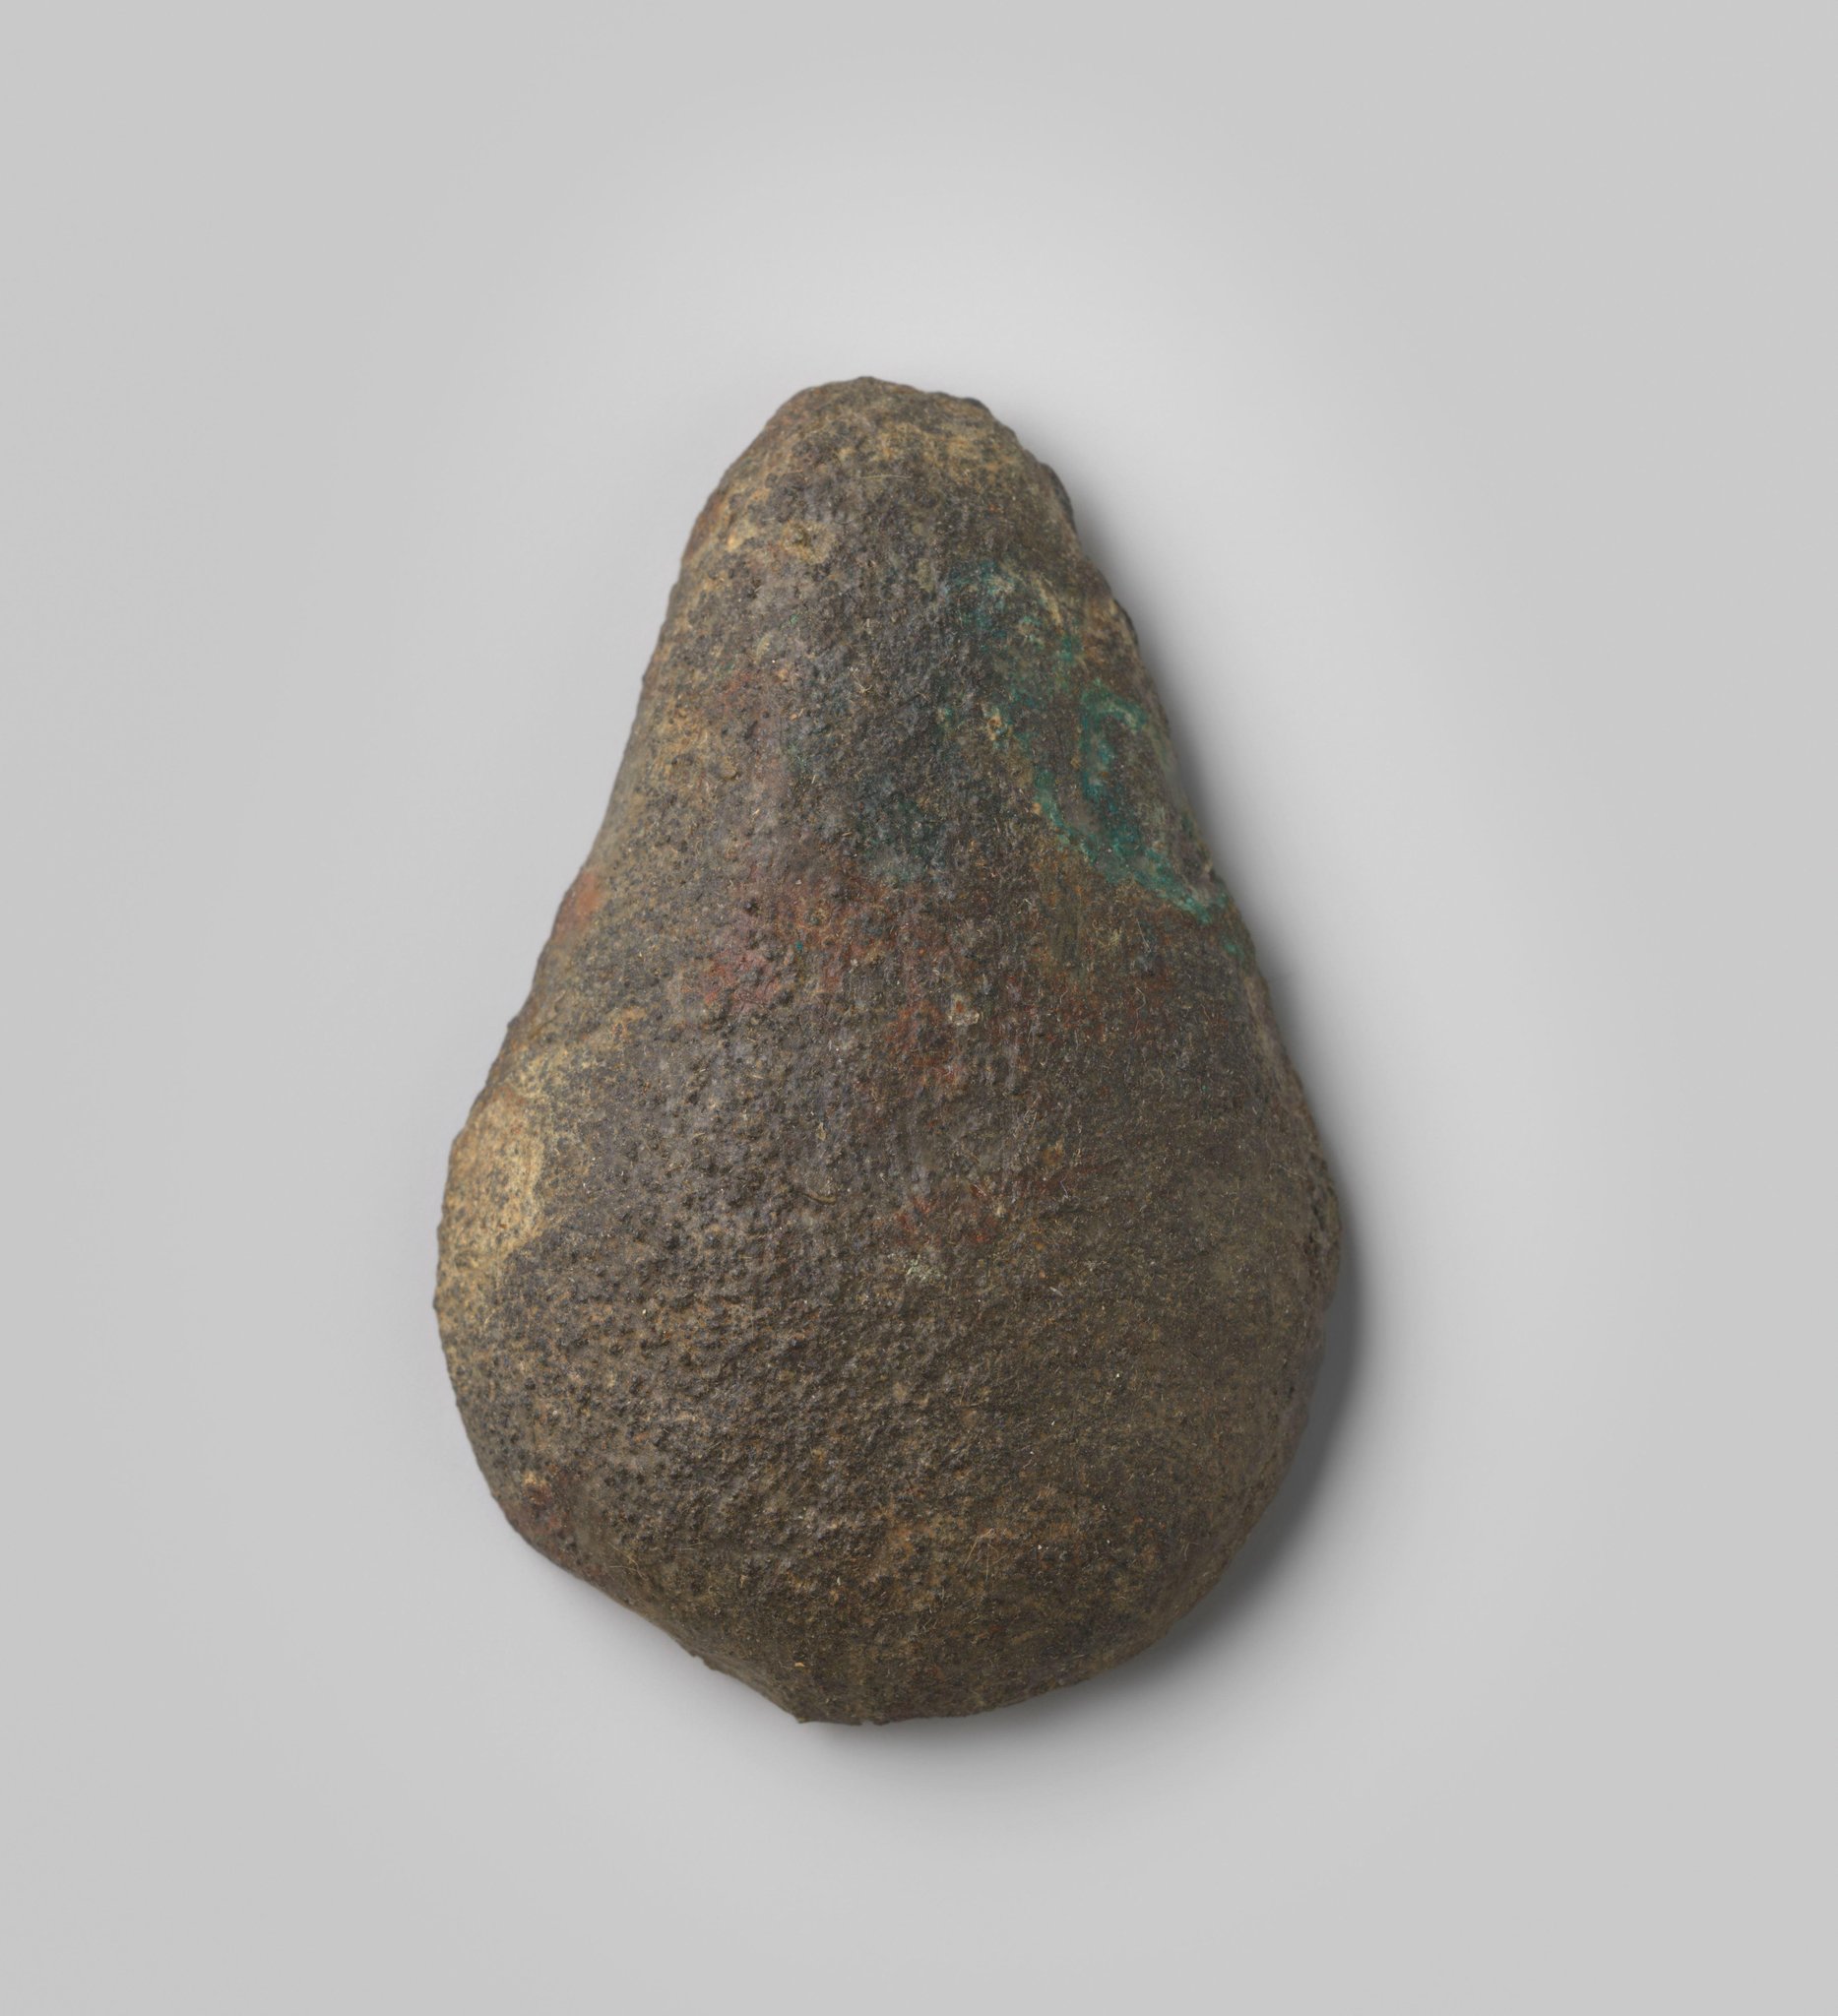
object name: gietwerk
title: Gietwerk uit het wrak van de Oost-Indiëvaarder Hollandia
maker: Anonymous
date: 1700-1743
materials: lead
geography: netherlands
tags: verenigde oostindische compagnie, hollandia (schip), annet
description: Casting; pear-shaped, one flat side, other side slightly convex.